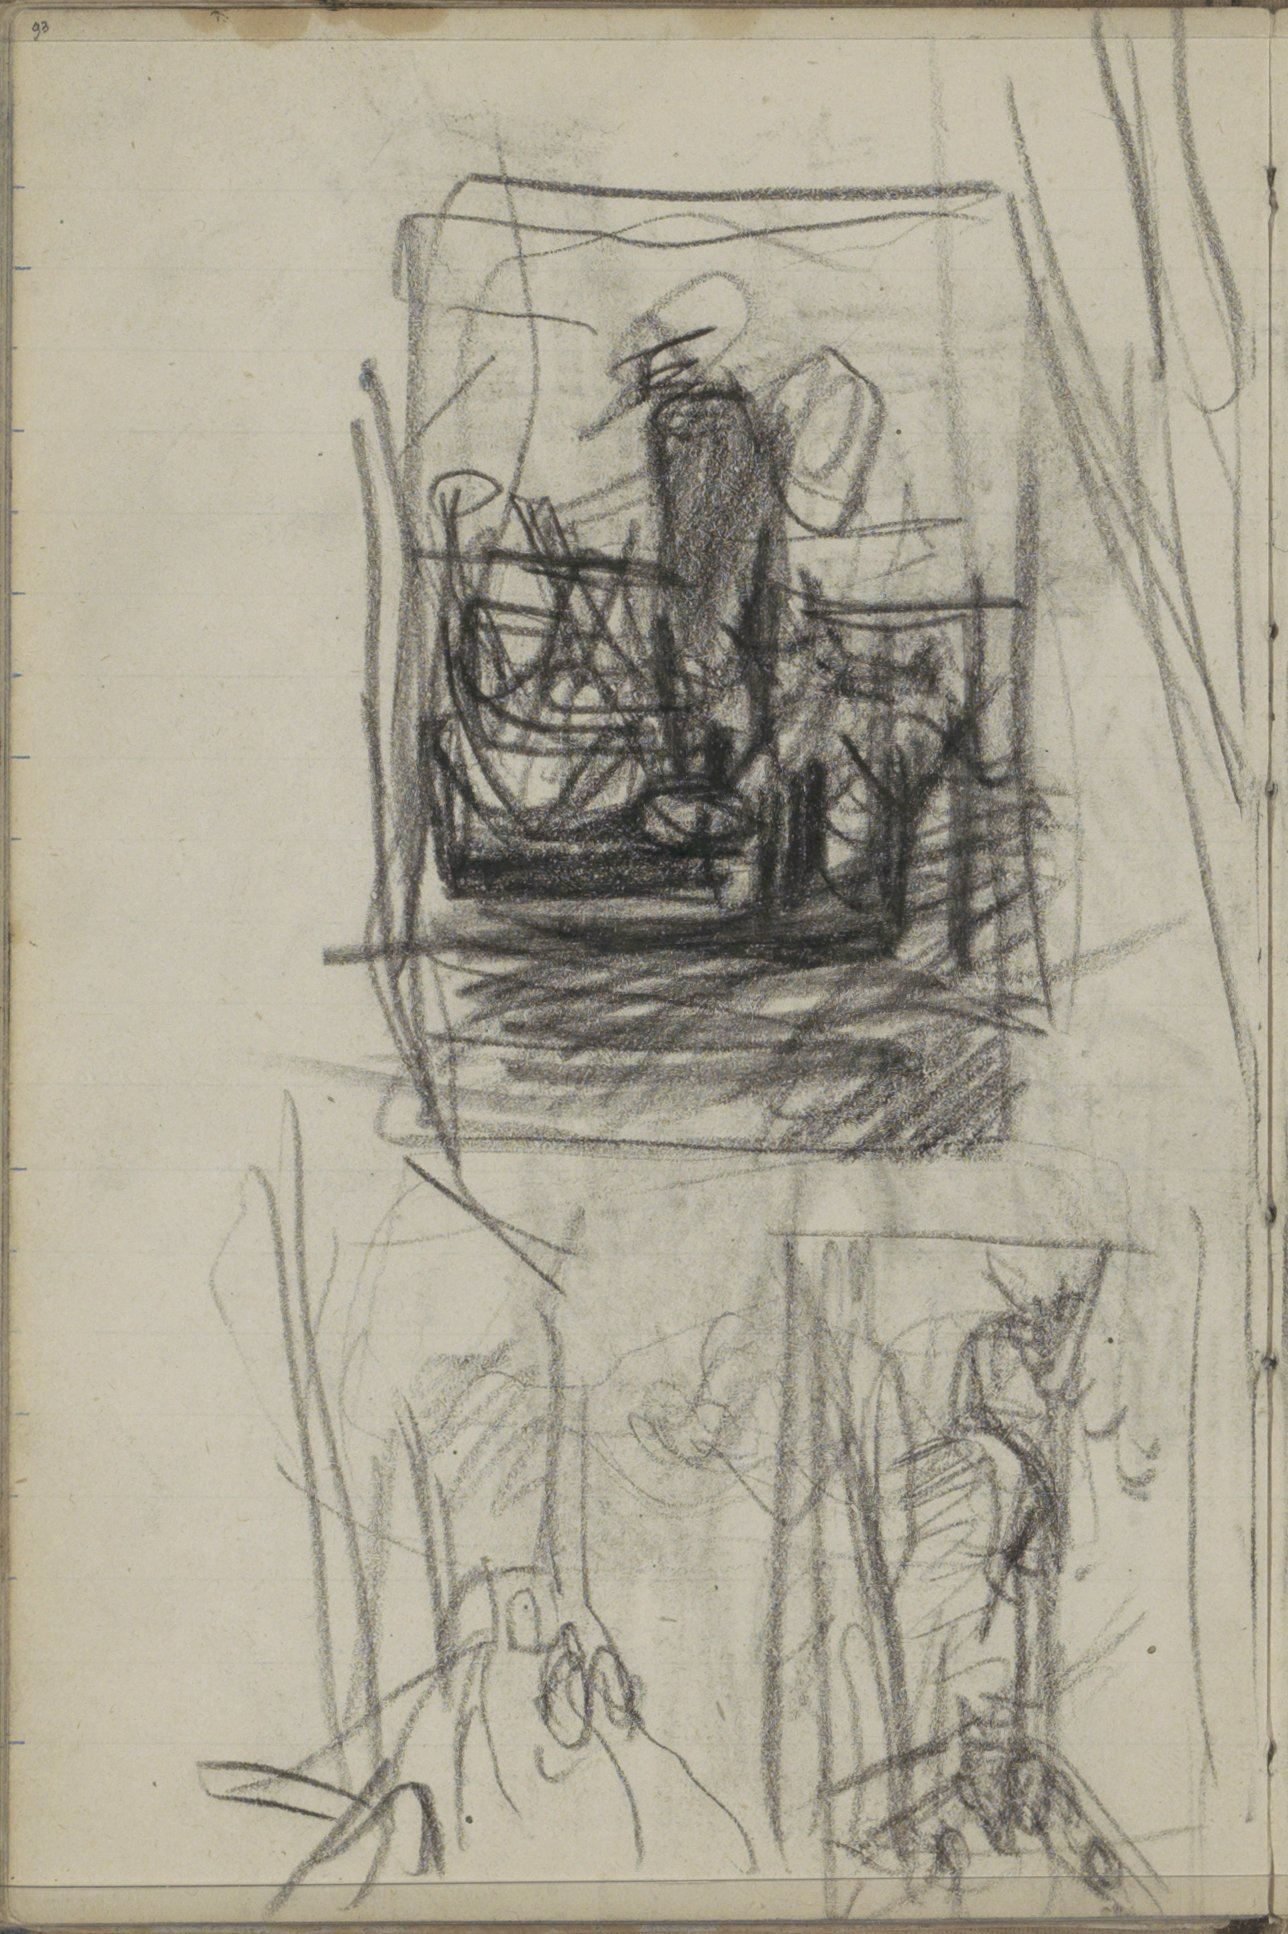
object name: sketchbook leaf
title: Studieblad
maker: marius bauer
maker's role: draughtsman, print maker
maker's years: 1867-1932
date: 1888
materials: chalk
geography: istanbul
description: Pagina 93 uit een schetsboek met 58 bladen.